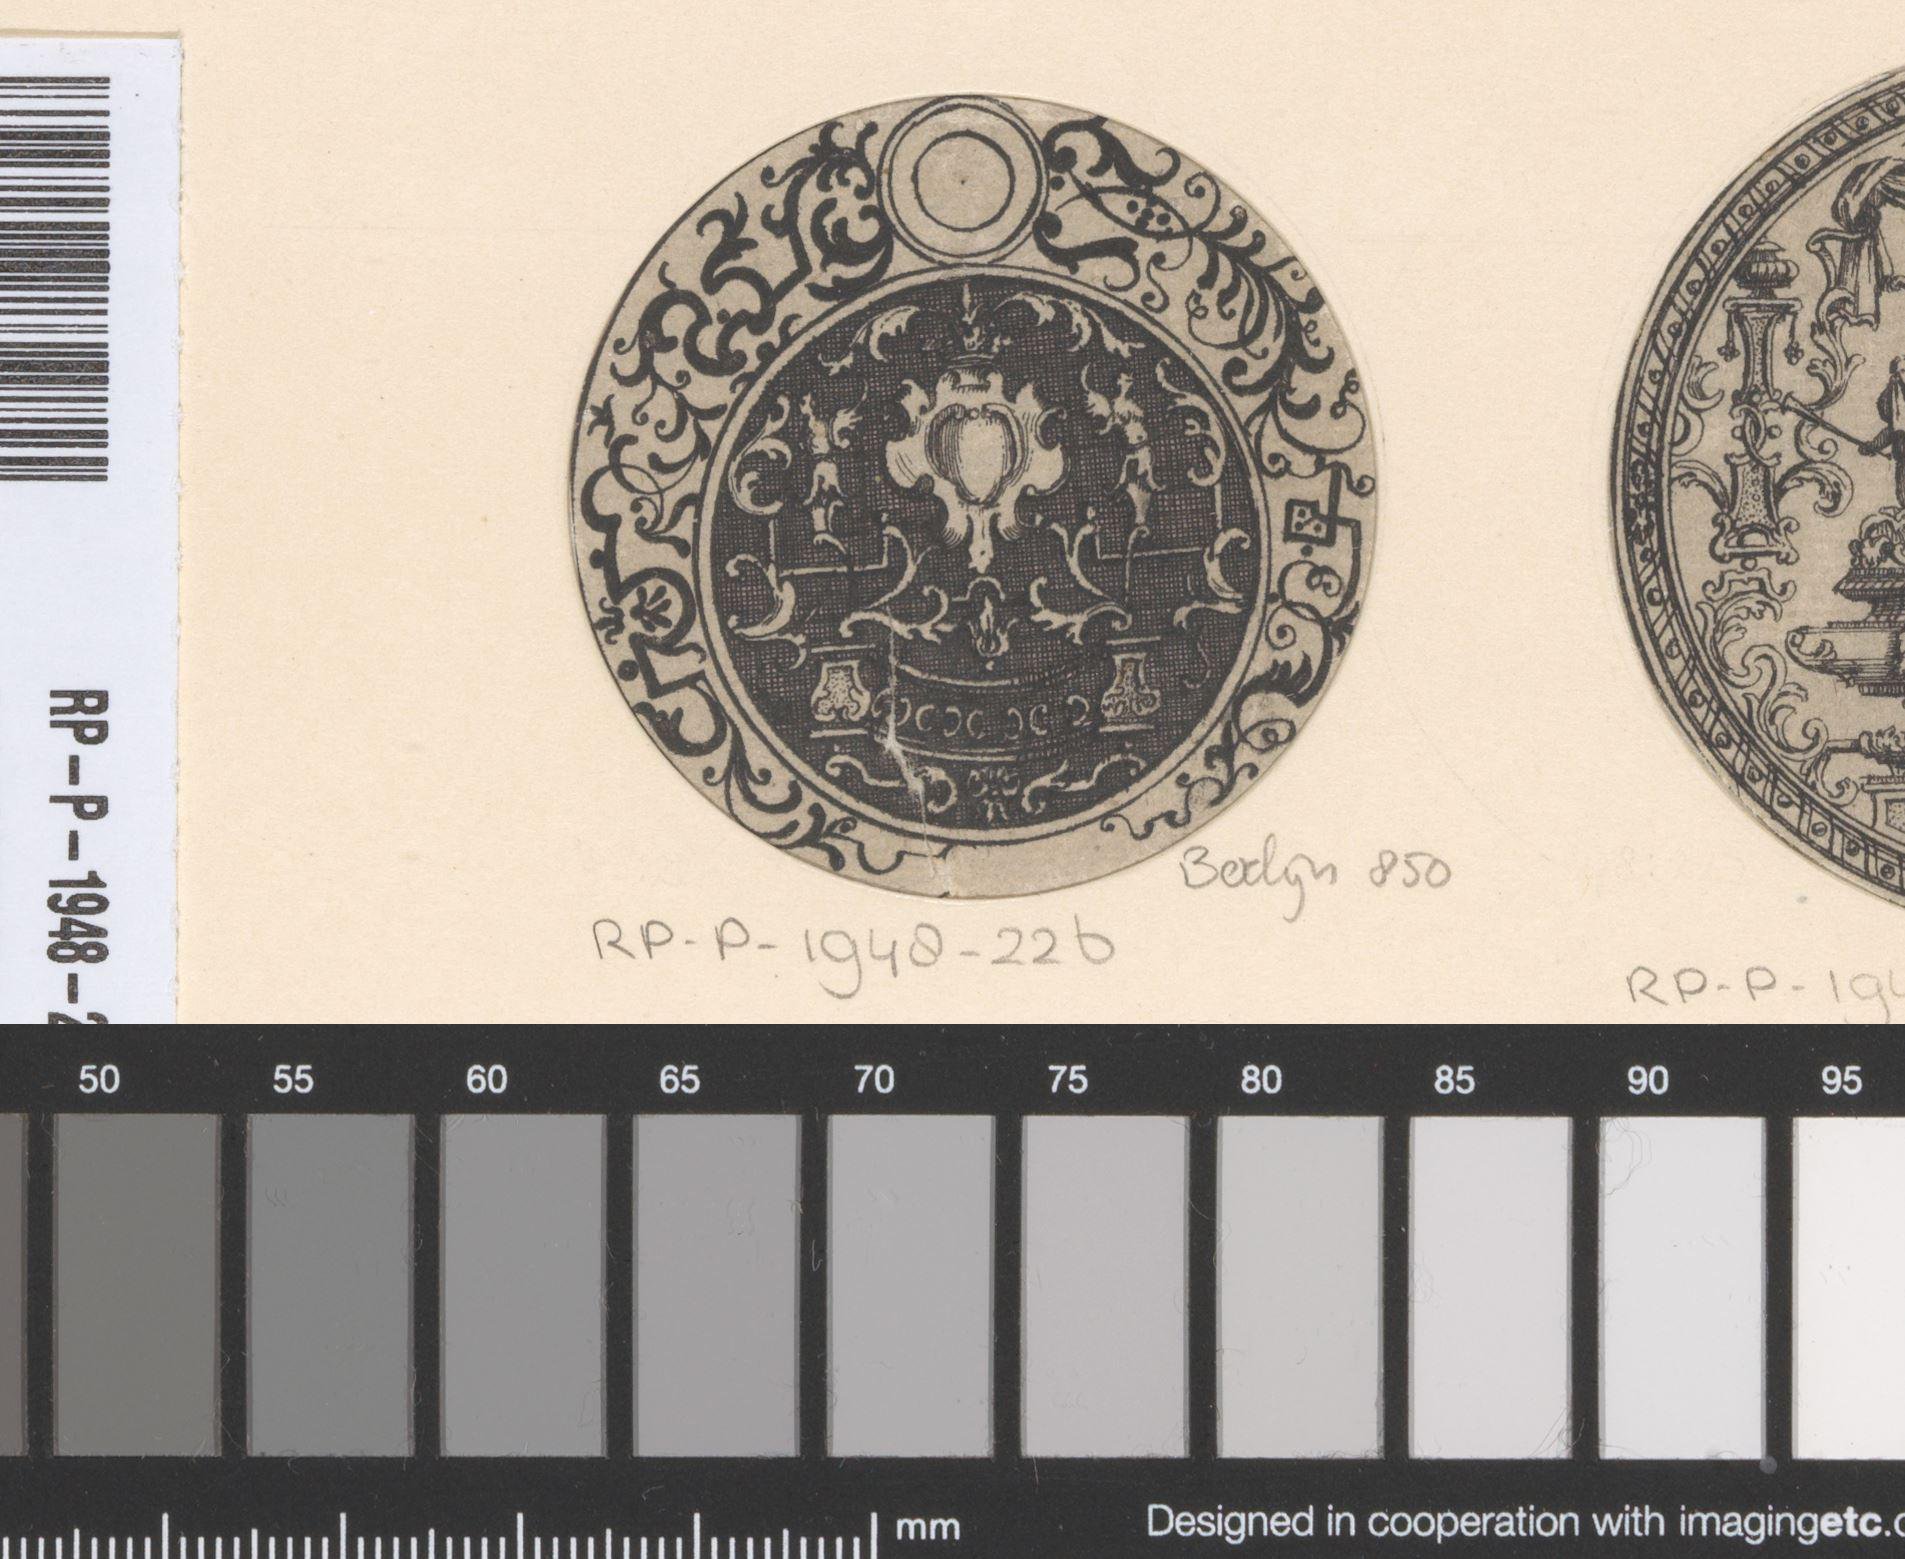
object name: ornament print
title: Cirkelvulling met cartouche en vlechtwerk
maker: Anonymous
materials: paper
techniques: etching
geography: paris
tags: interlace ~ ornament, ornament ~ cartouche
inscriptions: collector's mark: Lugt 2760, collector's mark: Lugt 2228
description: Een rocaille cartouche omringd door vlechtwerk en bladmotieven.